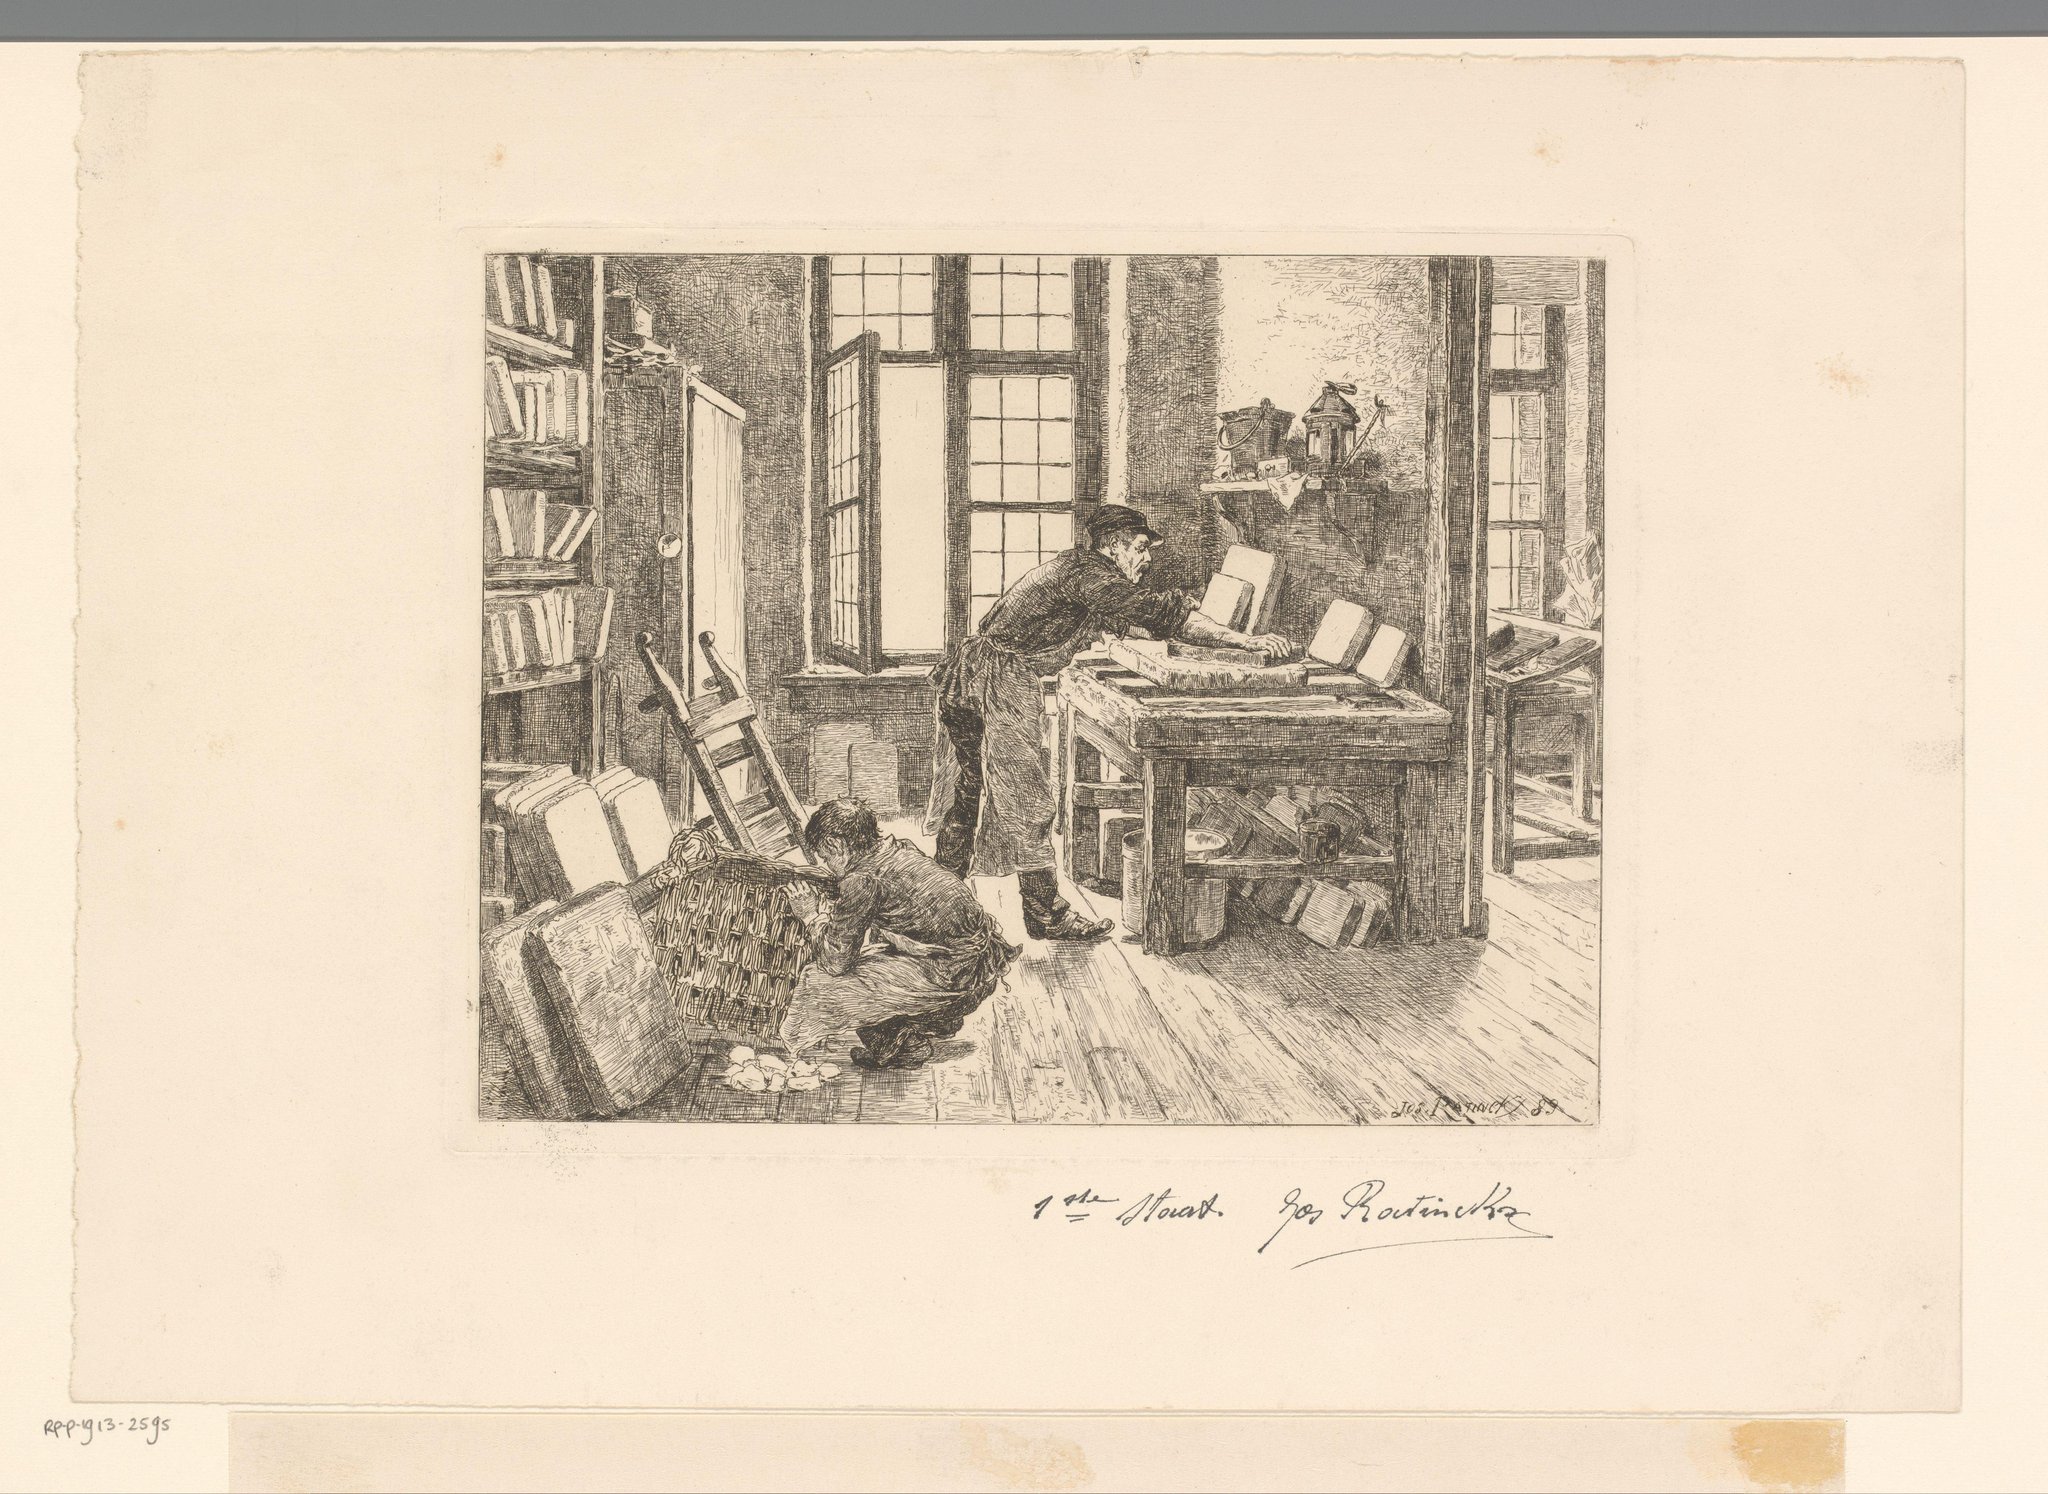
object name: print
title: Lithograaf aan het werk in zijn werkplaats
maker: jos ratinckx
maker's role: print maker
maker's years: 1860-1937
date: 1889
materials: paper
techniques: etching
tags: lithographer, artist at work, in his workshop, workshop-interior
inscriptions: inscription: ‘1ste staat’, collector's mark: Lugt 2228